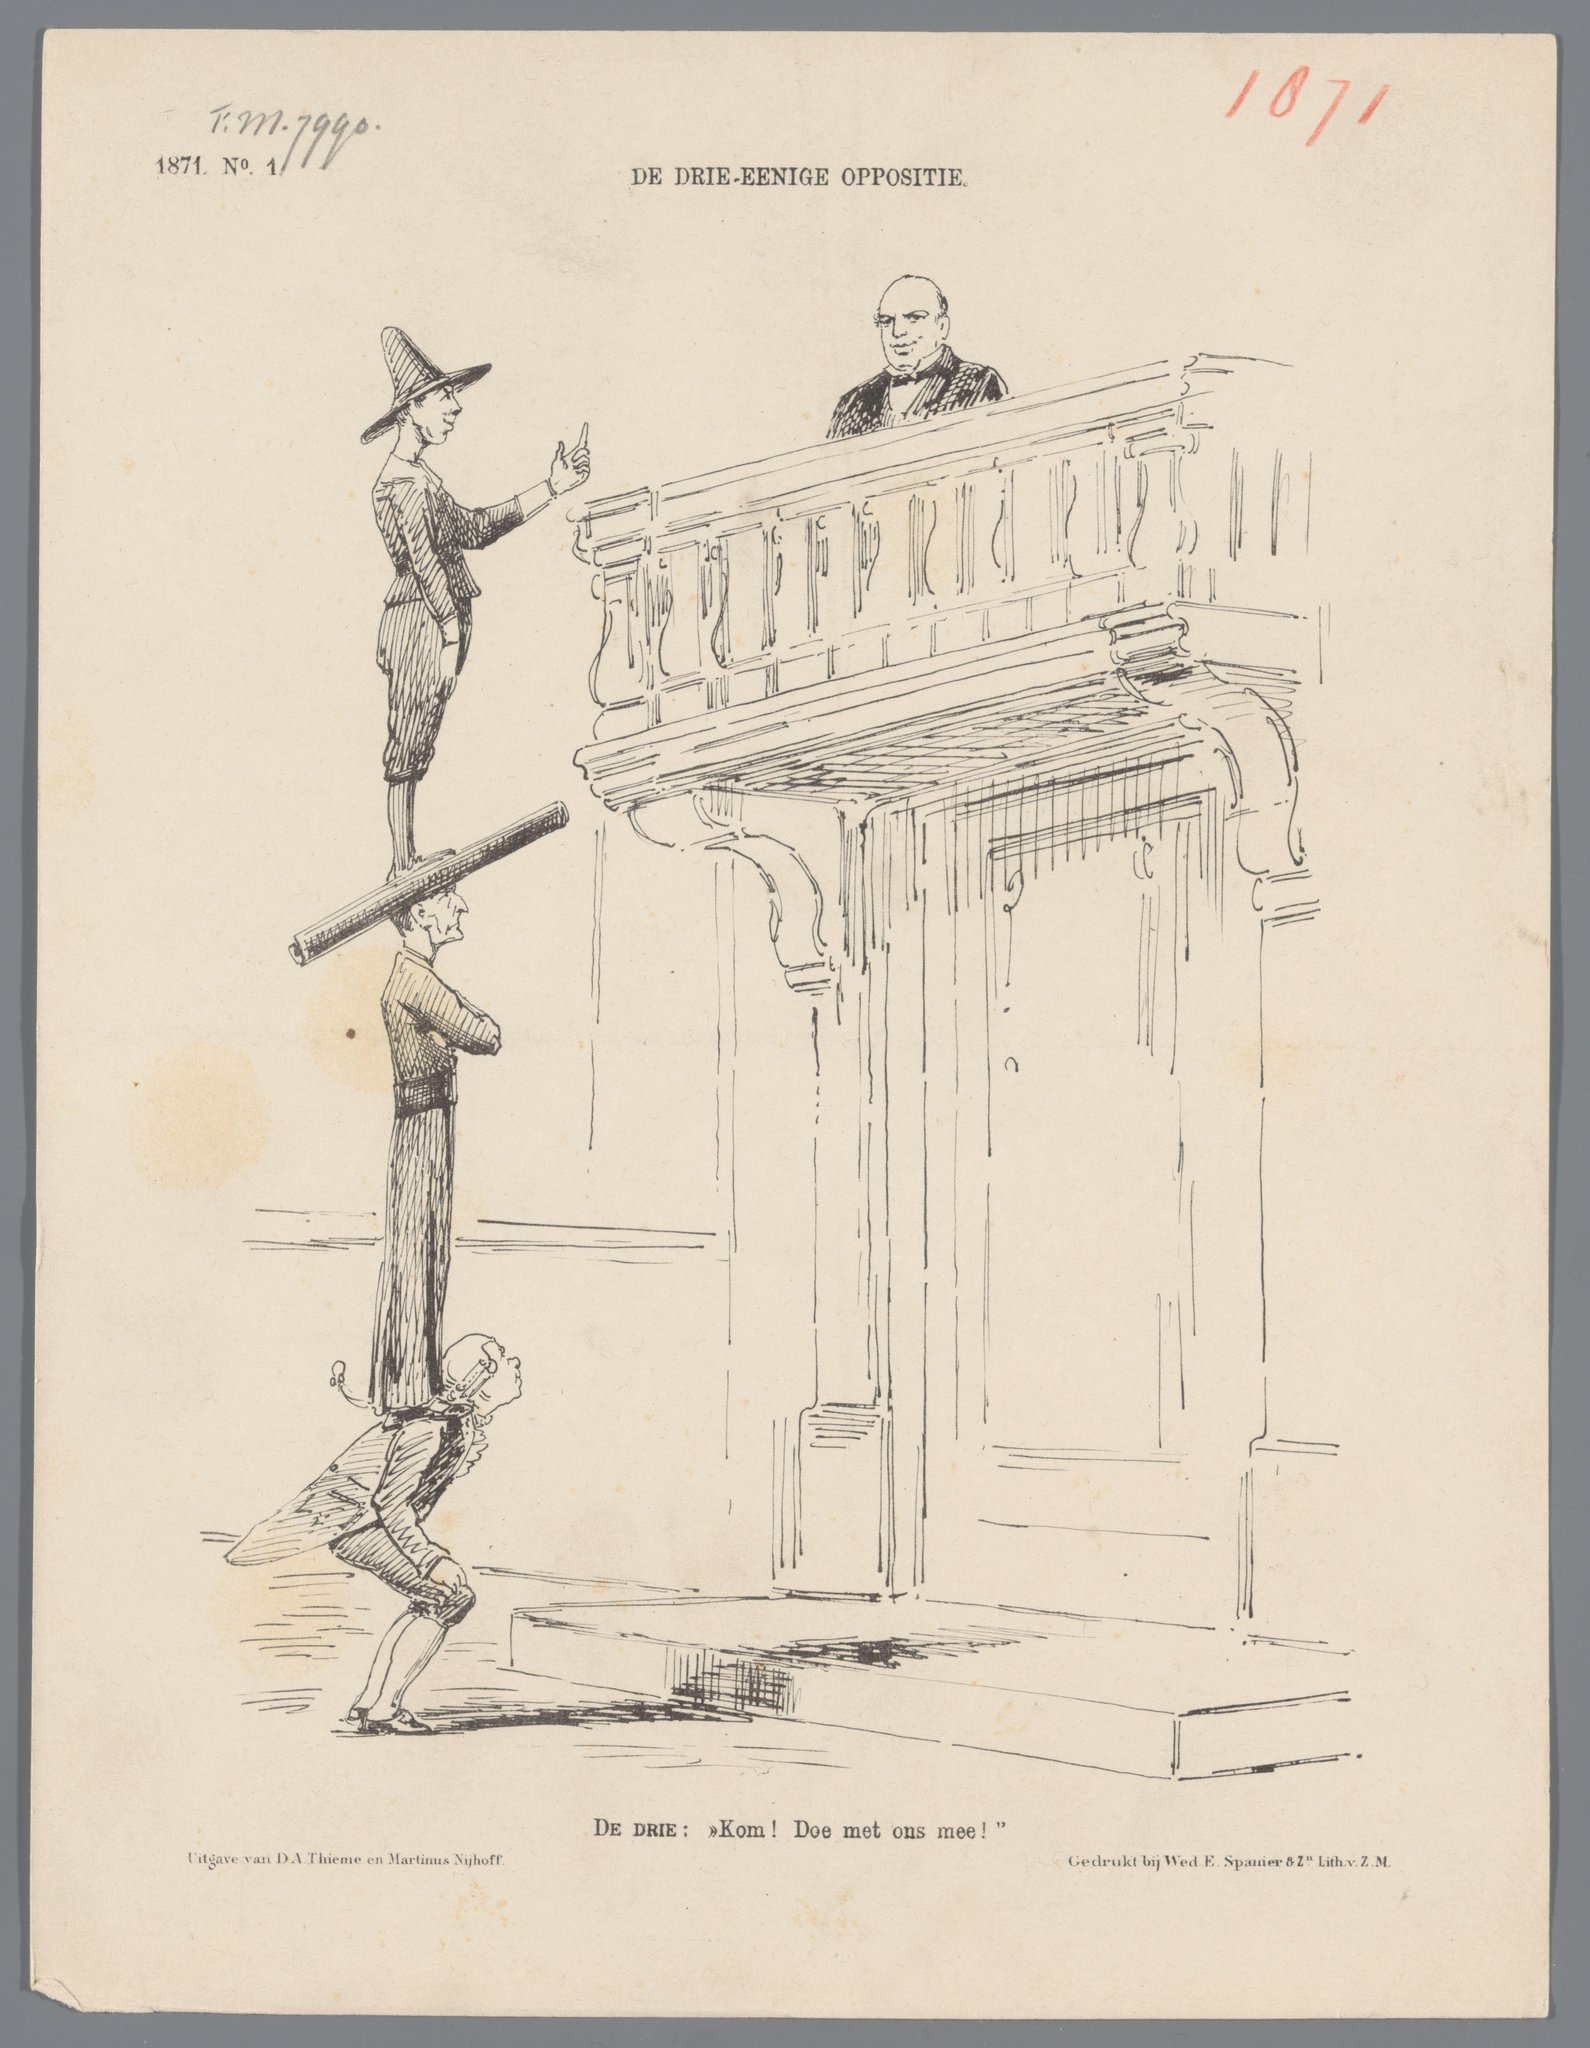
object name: print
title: Spotprent op het monsterverbond van de oppostie, 1871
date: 1871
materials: paper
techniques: lithograph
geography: the hague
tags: politician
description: Spotprent op de oppositie, samengesteld uit de conservatieven, ultramontijnen en antirevoltutionairen, die Fransen van de Putte uitnodigt mee te doen. Plaat verschenen bij het weekblad De Nederlandsche Spectator, nr. 1, 1871.